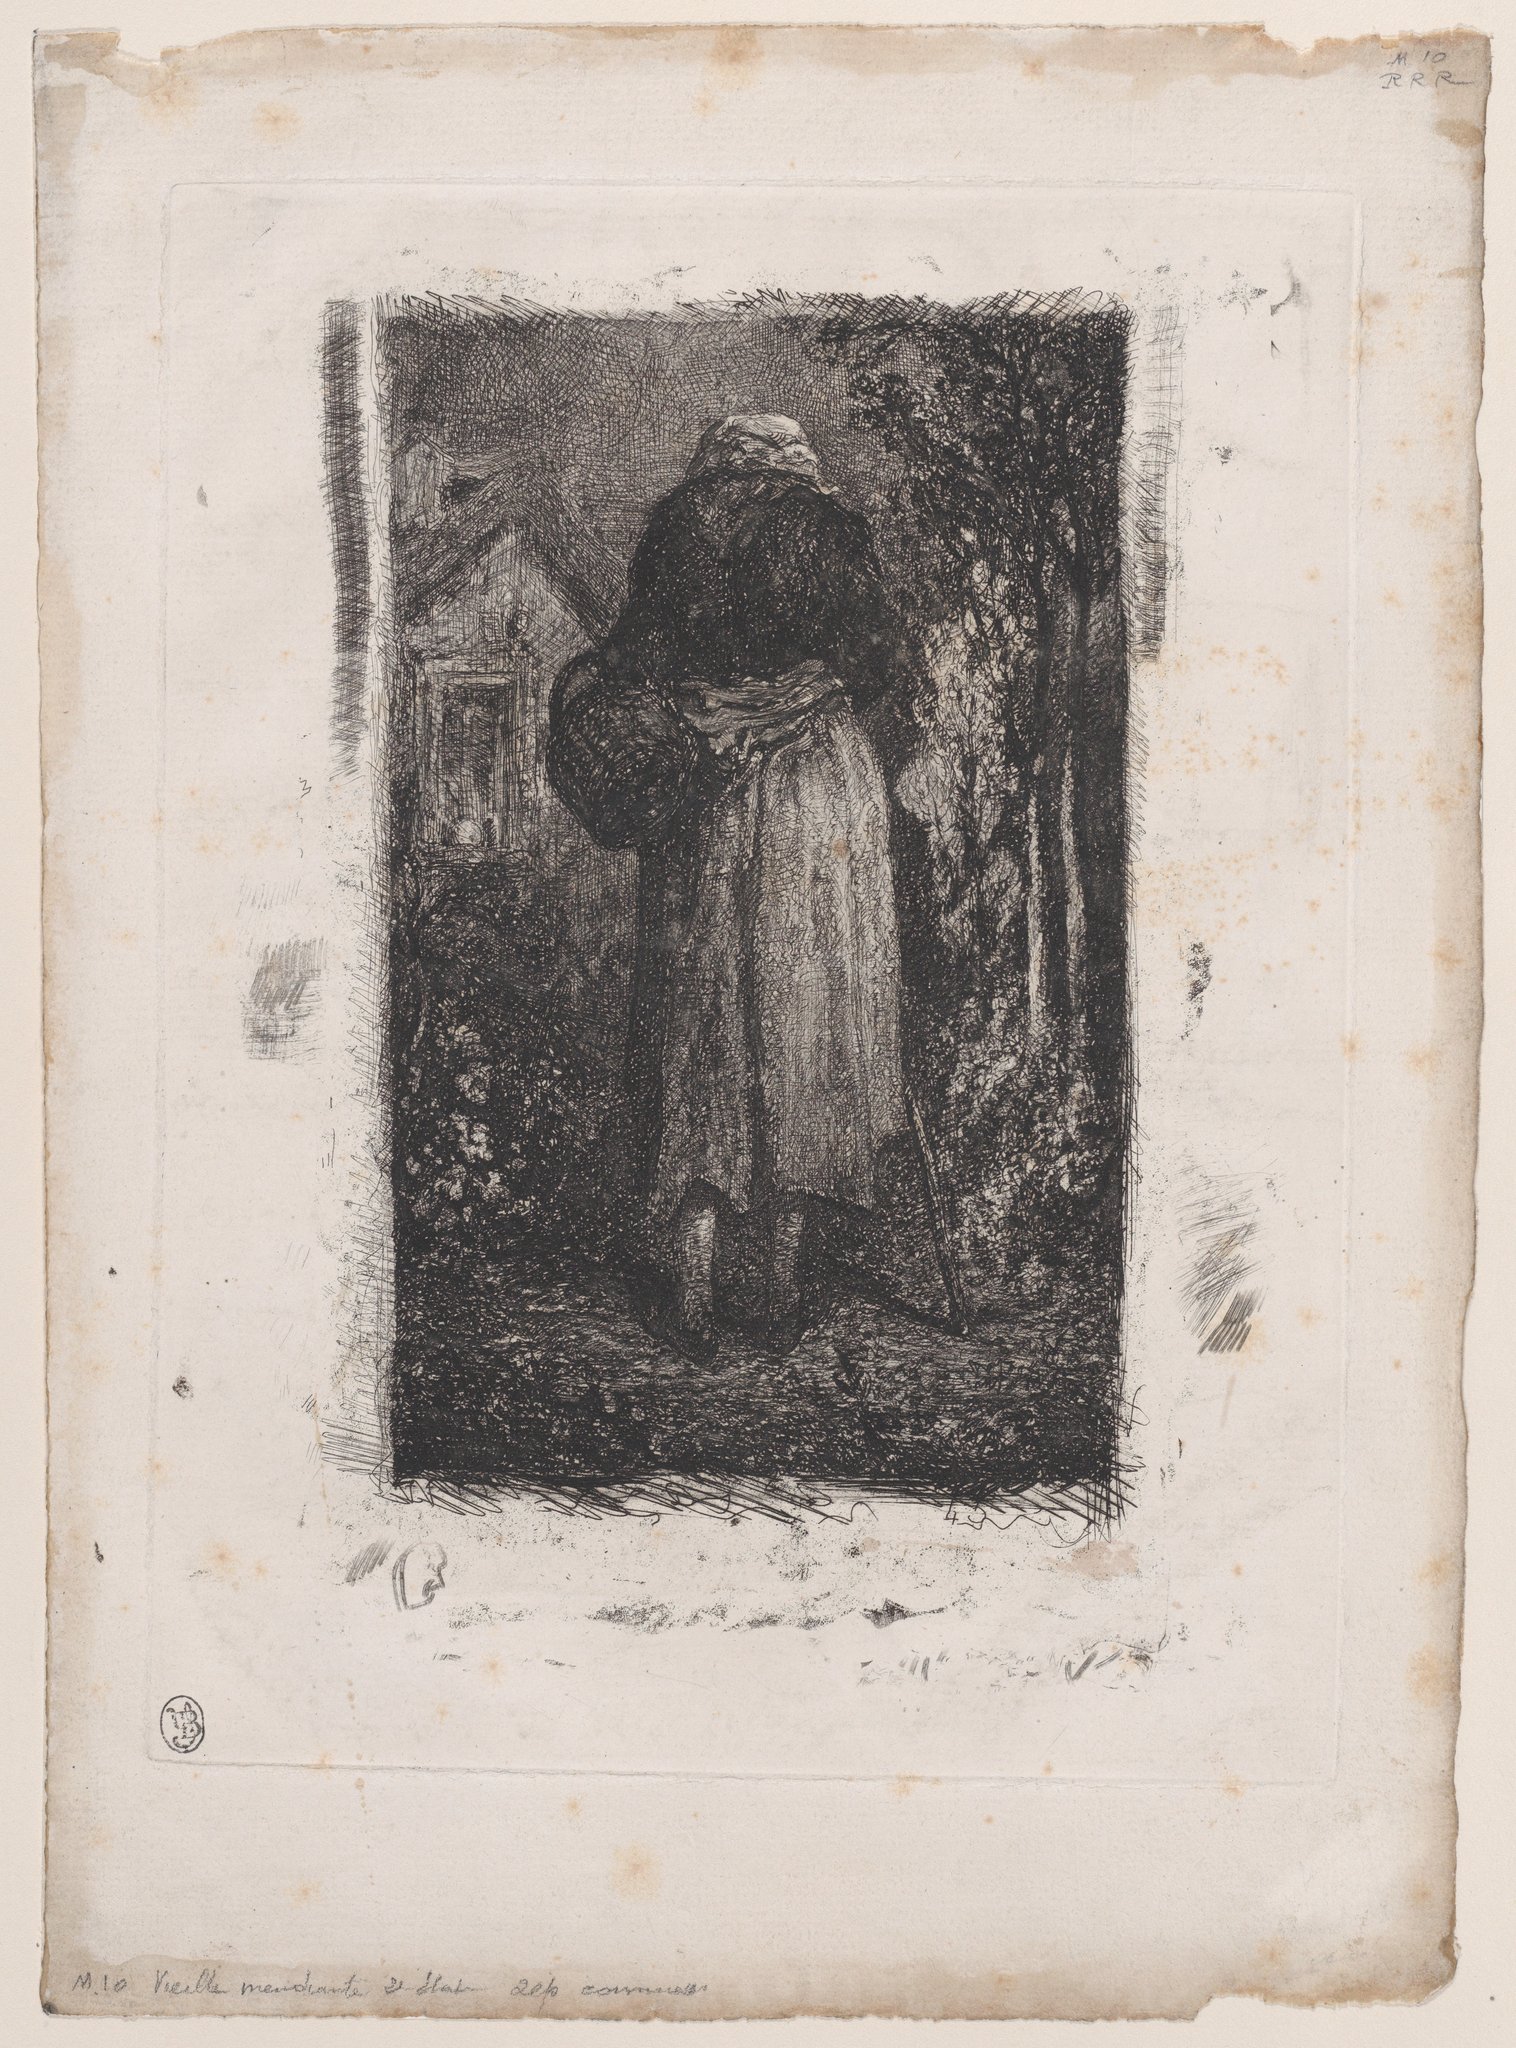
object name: print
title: Old Beggar Woman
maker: alexandre-gabriel decamps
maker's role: artist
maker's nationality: french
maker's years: 1803-1860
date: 1833-1838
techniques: drypoint, etching, roulette